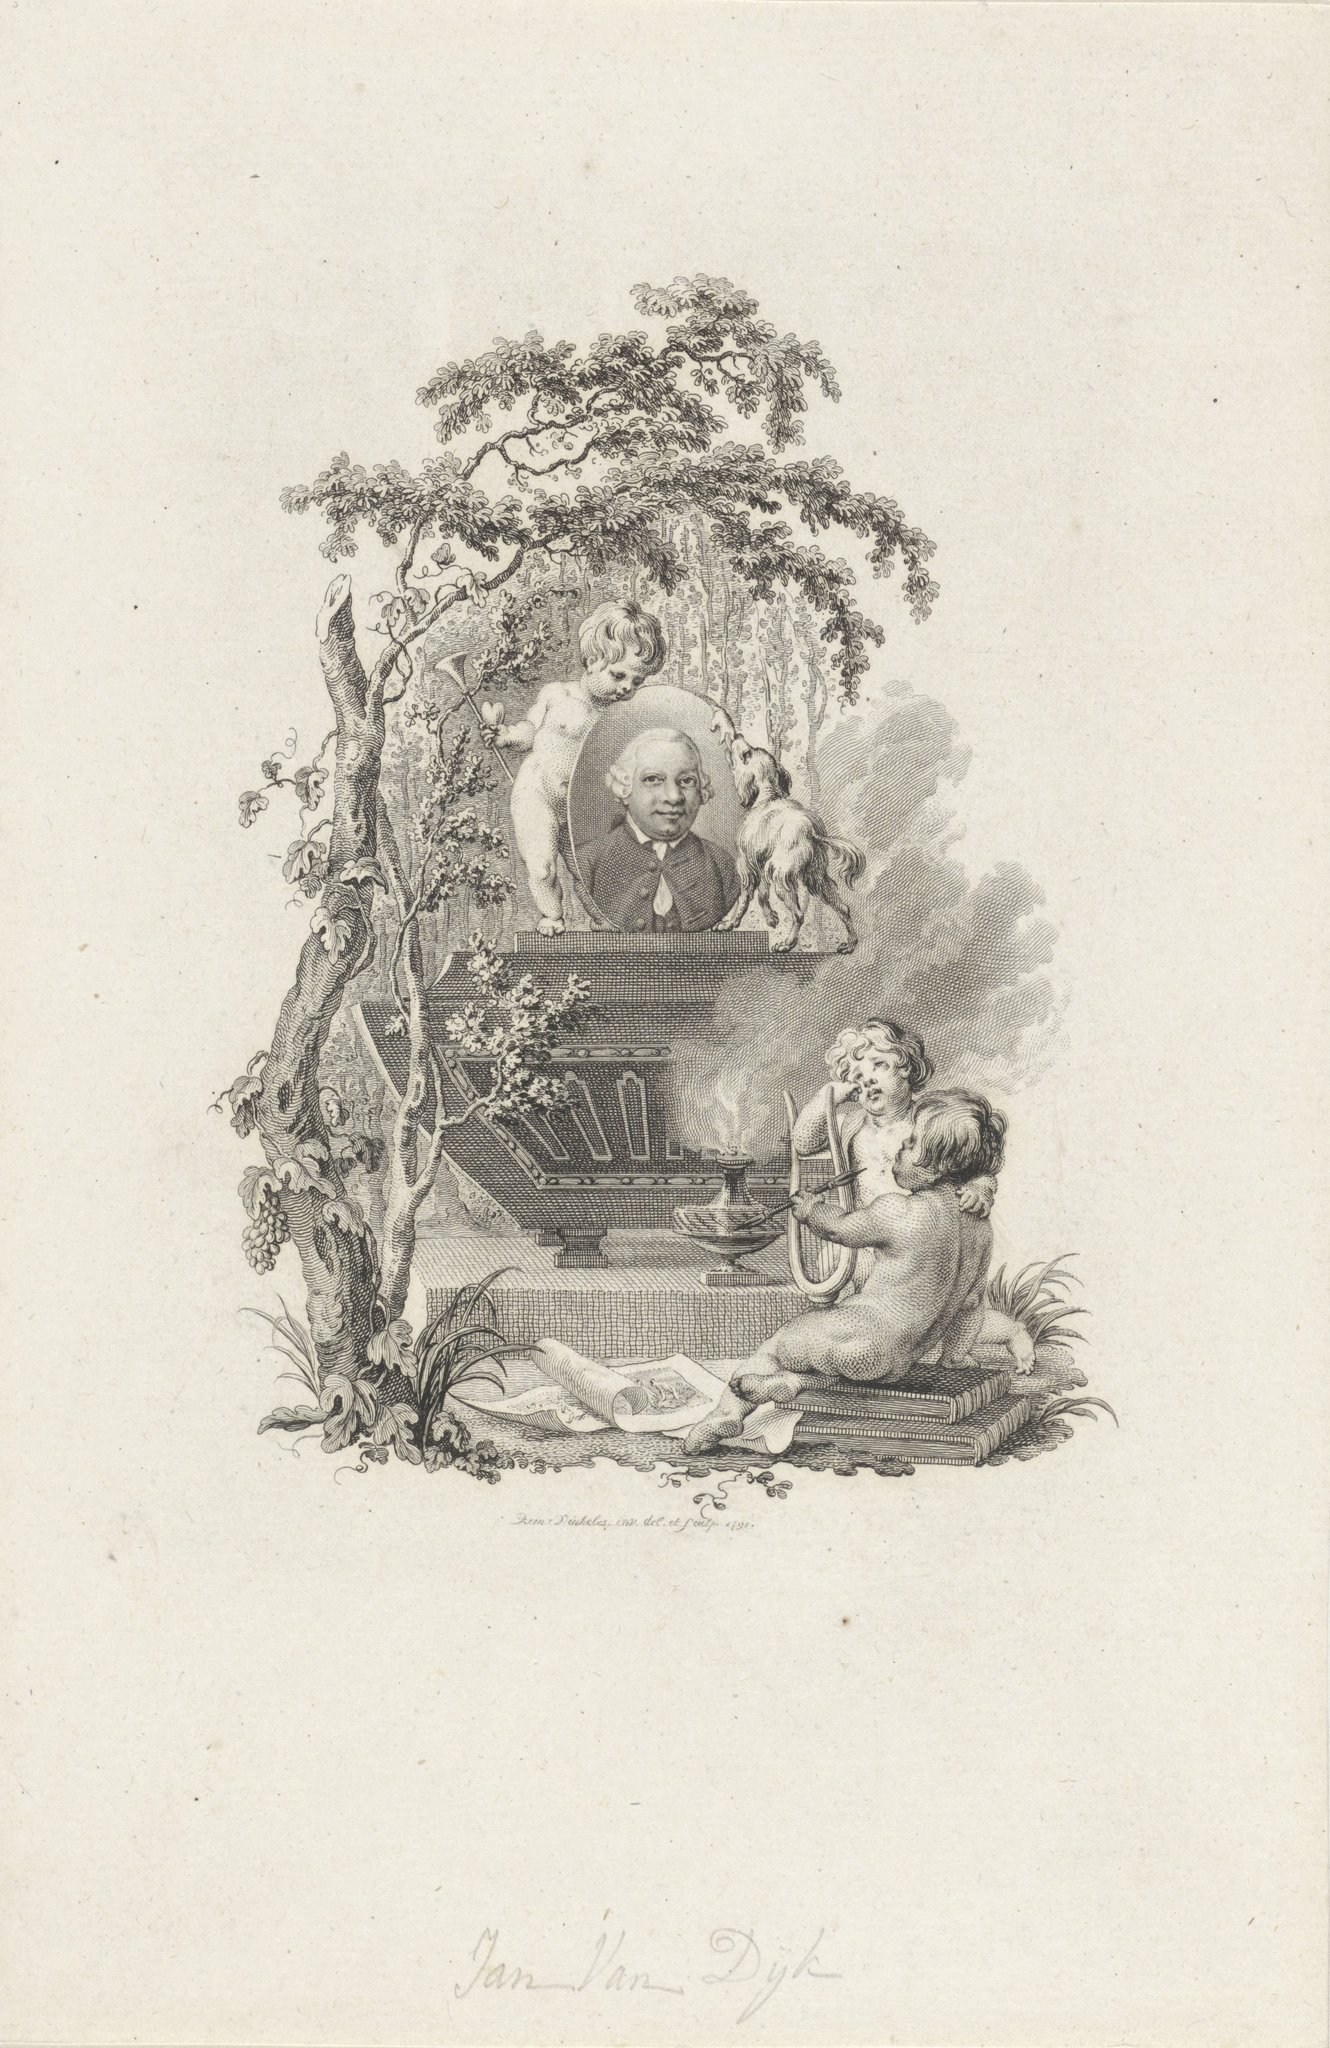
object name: print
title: Allegorisch portret van Jan van Dijk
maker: reinier vinkeles (i)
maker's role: draughtsman, print maker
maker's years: 1741-1816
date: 1791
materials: paper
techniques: engraving, etching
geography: amsterdam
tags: grave, tomb, cupids: 'amores', 'amoretti', 'putti', dog, smoking pot as symbol of 'vanitas'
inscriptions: collector's mark: Lugt 240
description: Allegorische voorstelling op het overlijden van Jan van Dijk, kunstverzamelaar te Amsterdam. Op een graftombe wordt het portret van Jan van Dijk vastgehouden door een putto met in zijn hand een hart en een bazuin. Aan de andere kant een hond. Aan de voet van de graftombe een rokende pot en twee treurende putti. Vor hen op de grond liggen enkele tekeningen.